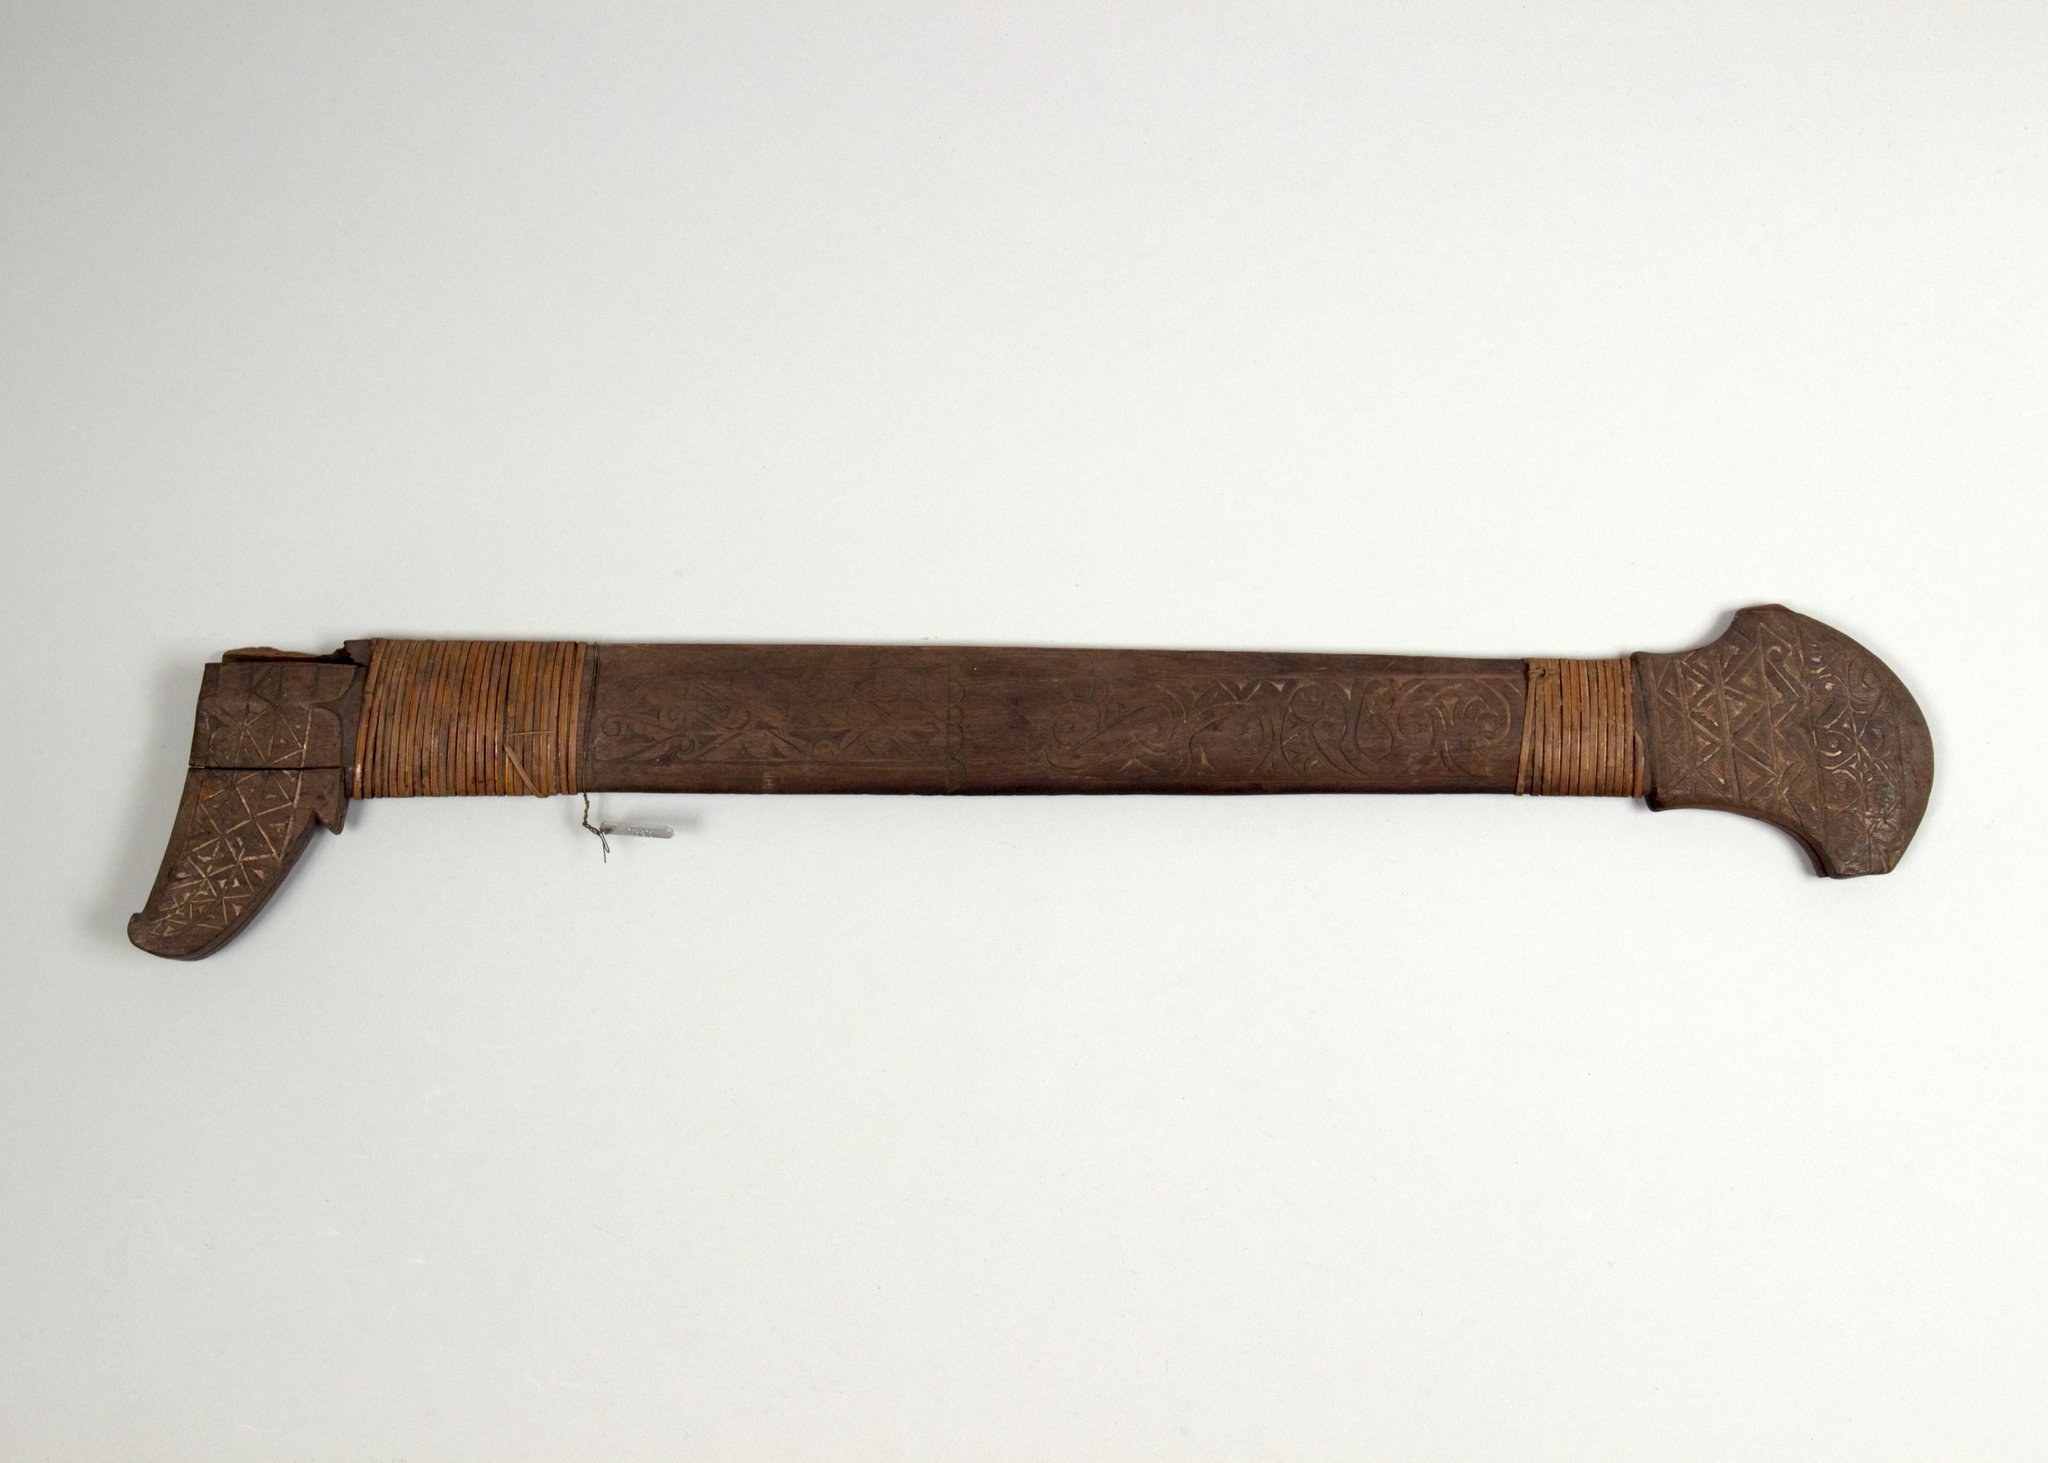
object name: kris with sheath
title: Sheath for a Kris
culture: philippine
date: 1701-1900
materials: wood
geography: philippines